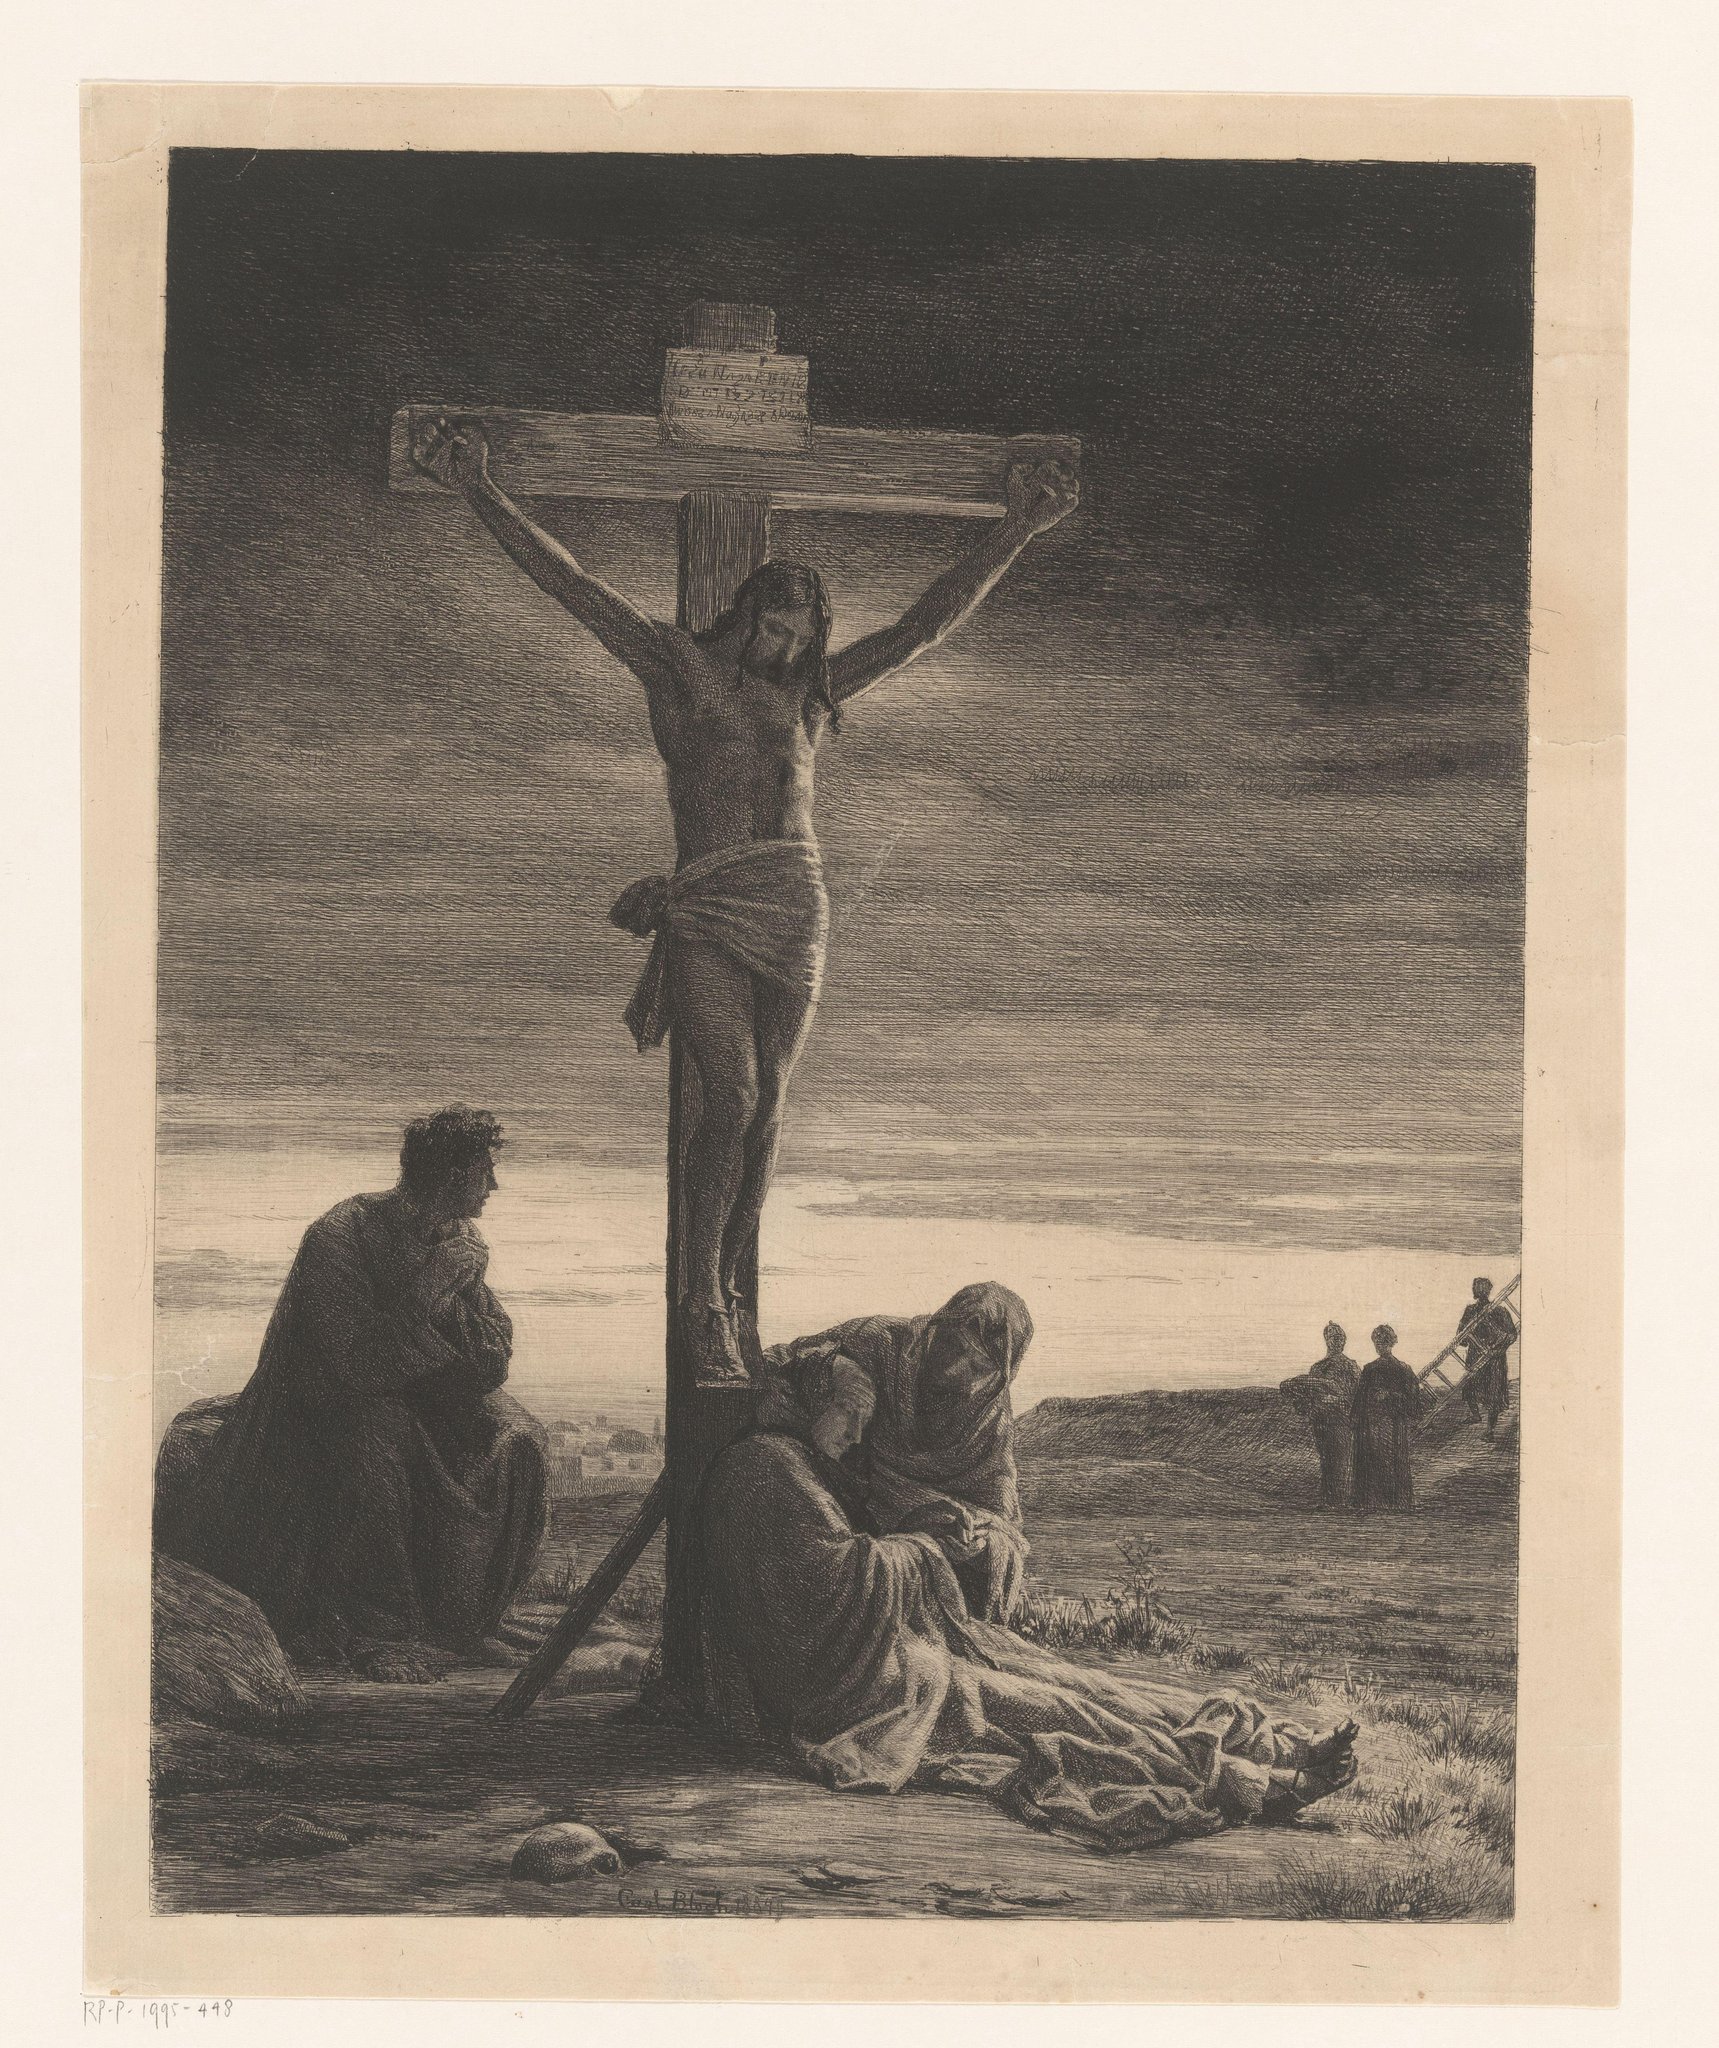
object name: print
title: Christus aan het kruis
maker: carl bloch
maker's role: print maker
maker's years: 1834-1890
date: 1884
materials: paper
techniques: drypoint, etching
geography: scandinavia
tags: crucified christ with mary, john, and mary magdalene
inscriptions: collector's mark: Lugt 2228, signature and date: ‘m.o. gesigneerd en gedateerd Carl Bloch 1884’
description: Christus aan het kruis; Johannes, Maria en Maria Magdalena bewenen hem. Rechts op de achtergrond naderen drie figuren met ladder en doeken.